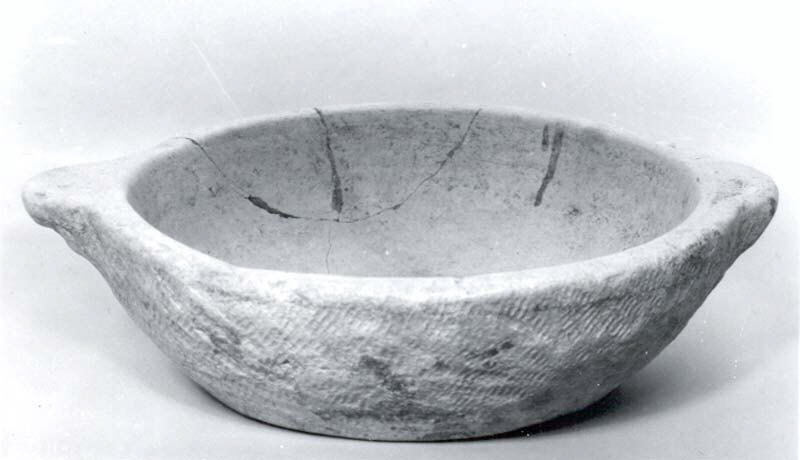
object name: bowl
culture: sasanian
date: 201-700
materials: limestone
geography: iran